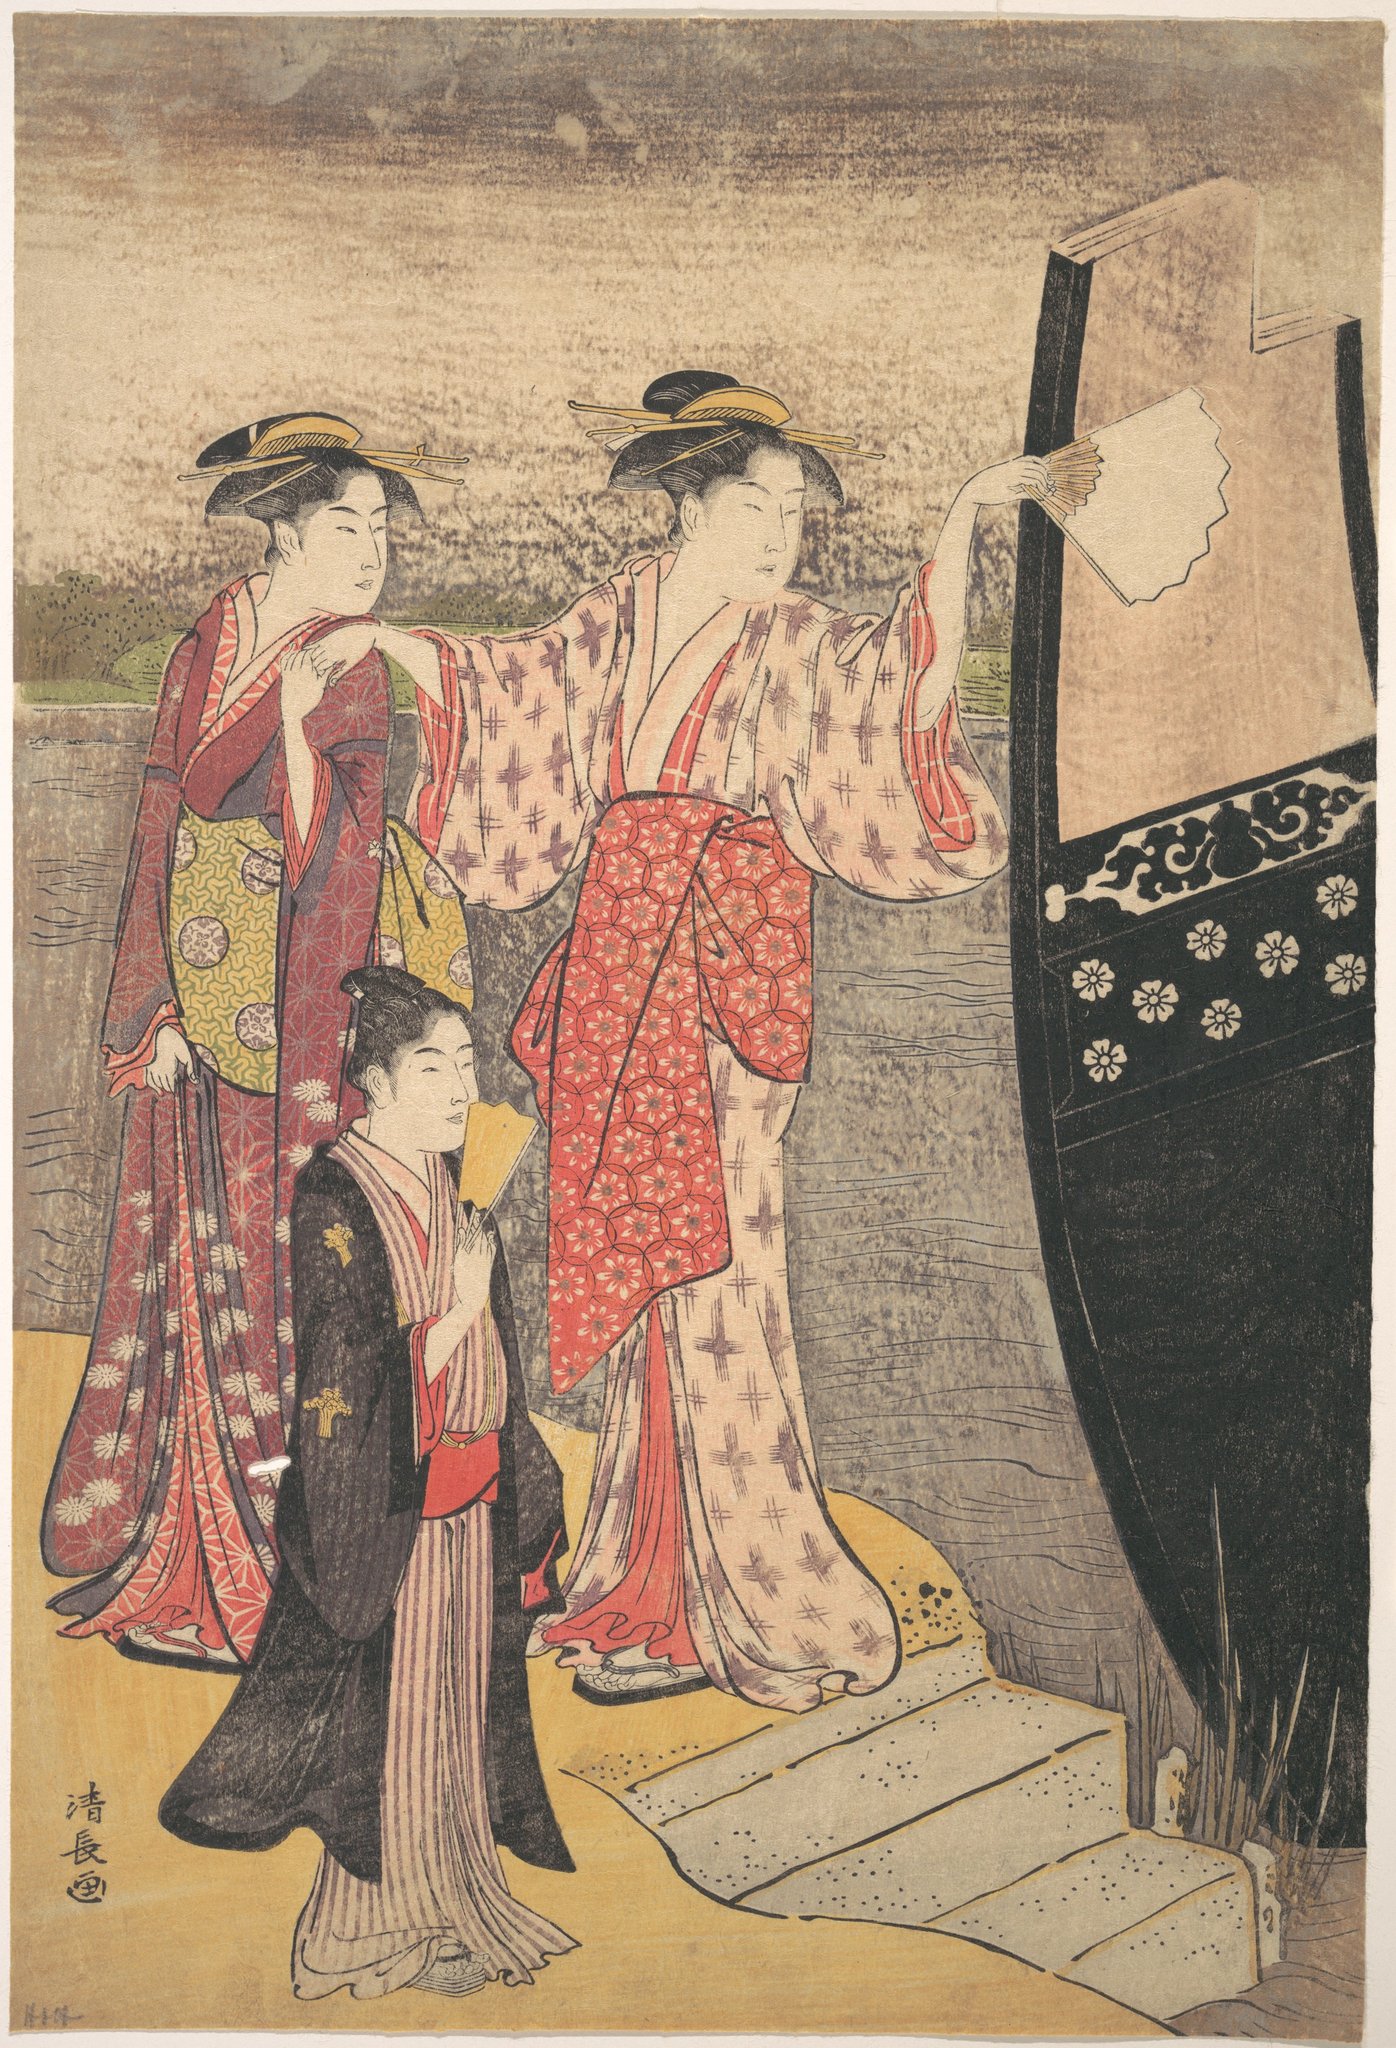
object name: woodblock print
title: Disembarking from a Pleasure Boat on the Sumida River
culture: japanese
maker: torii kiyonaga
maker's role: artist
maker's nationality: japanese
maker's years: 1752-1815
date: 1742-1815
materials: ink, paper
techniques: woodblock print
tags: women